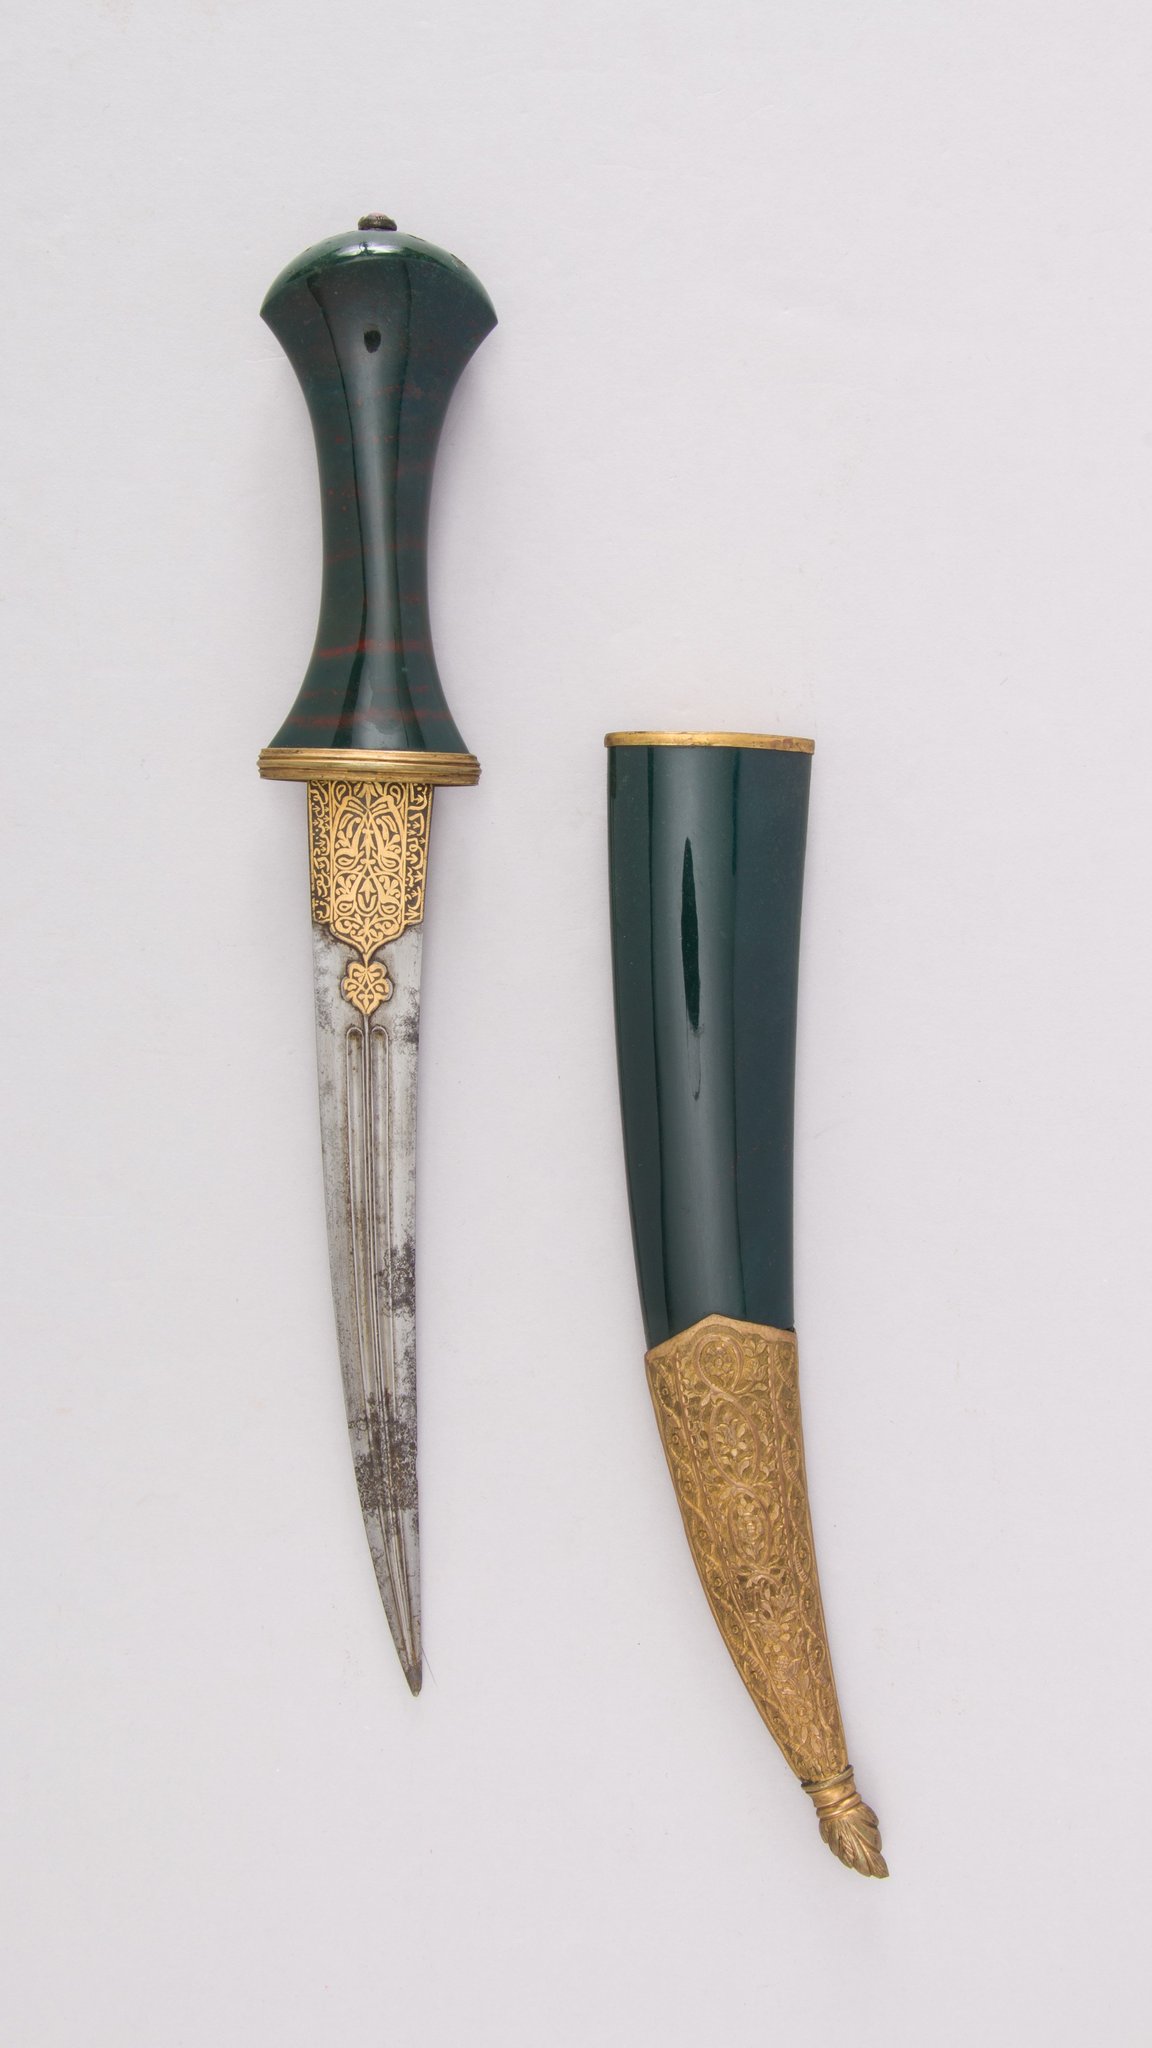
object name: dagger with sheath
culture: persian or turkish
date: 1701-1900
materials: copper, gold, gemstone, steel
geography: iran